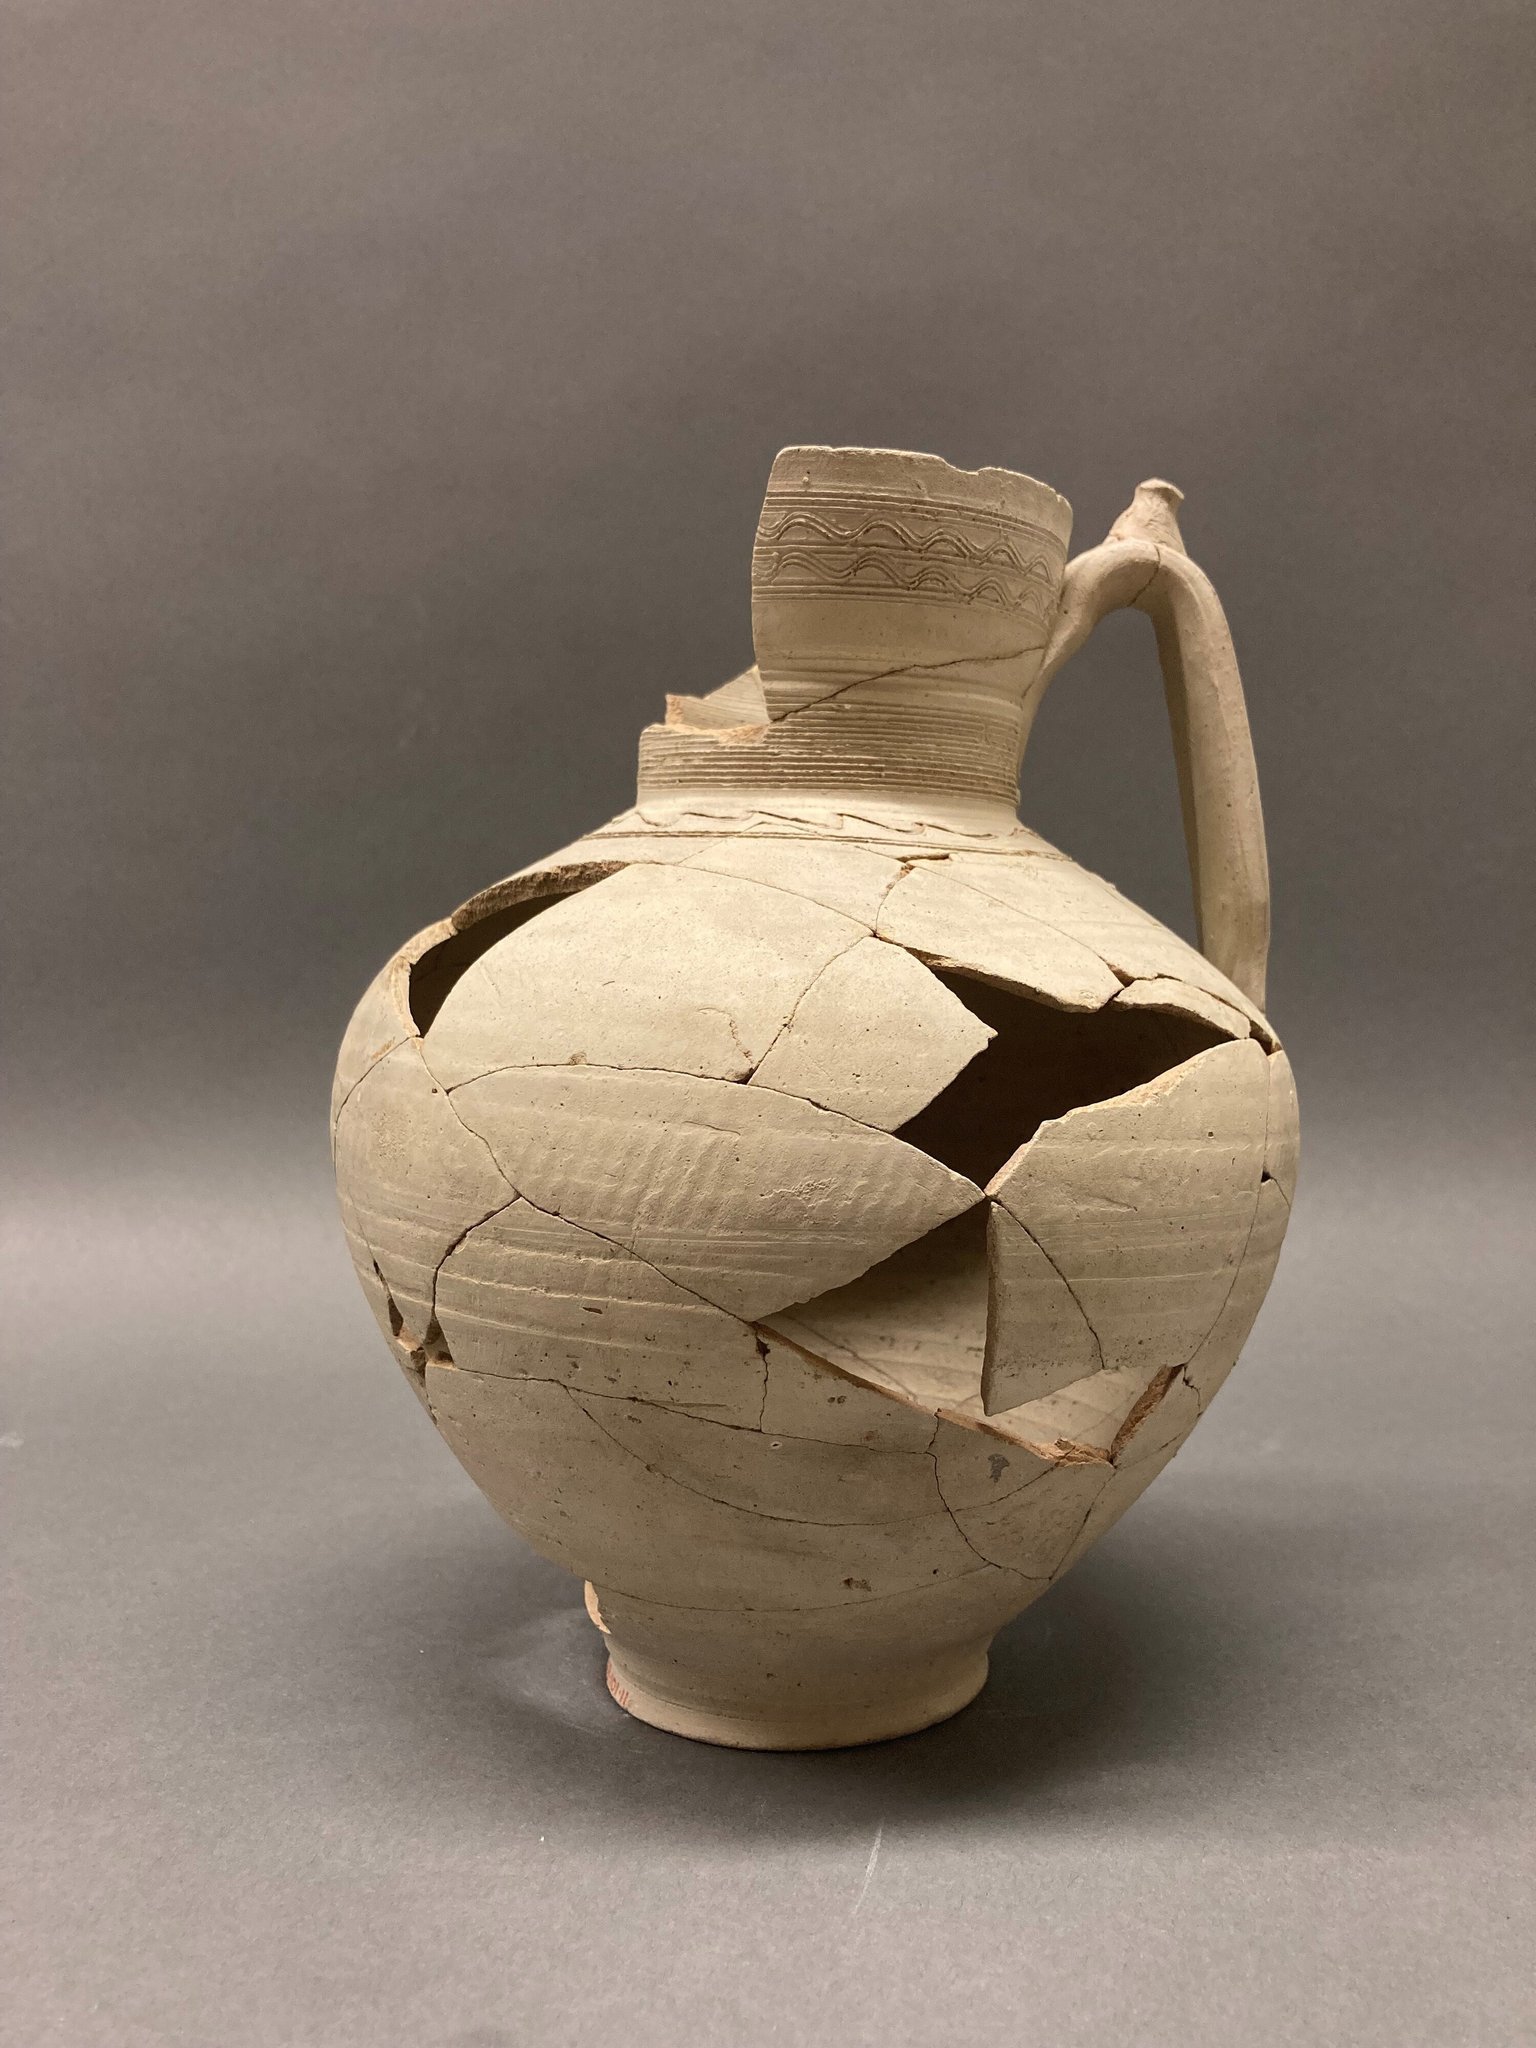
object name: ewer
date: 1001-1100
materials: earthenware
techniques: incising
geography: iran